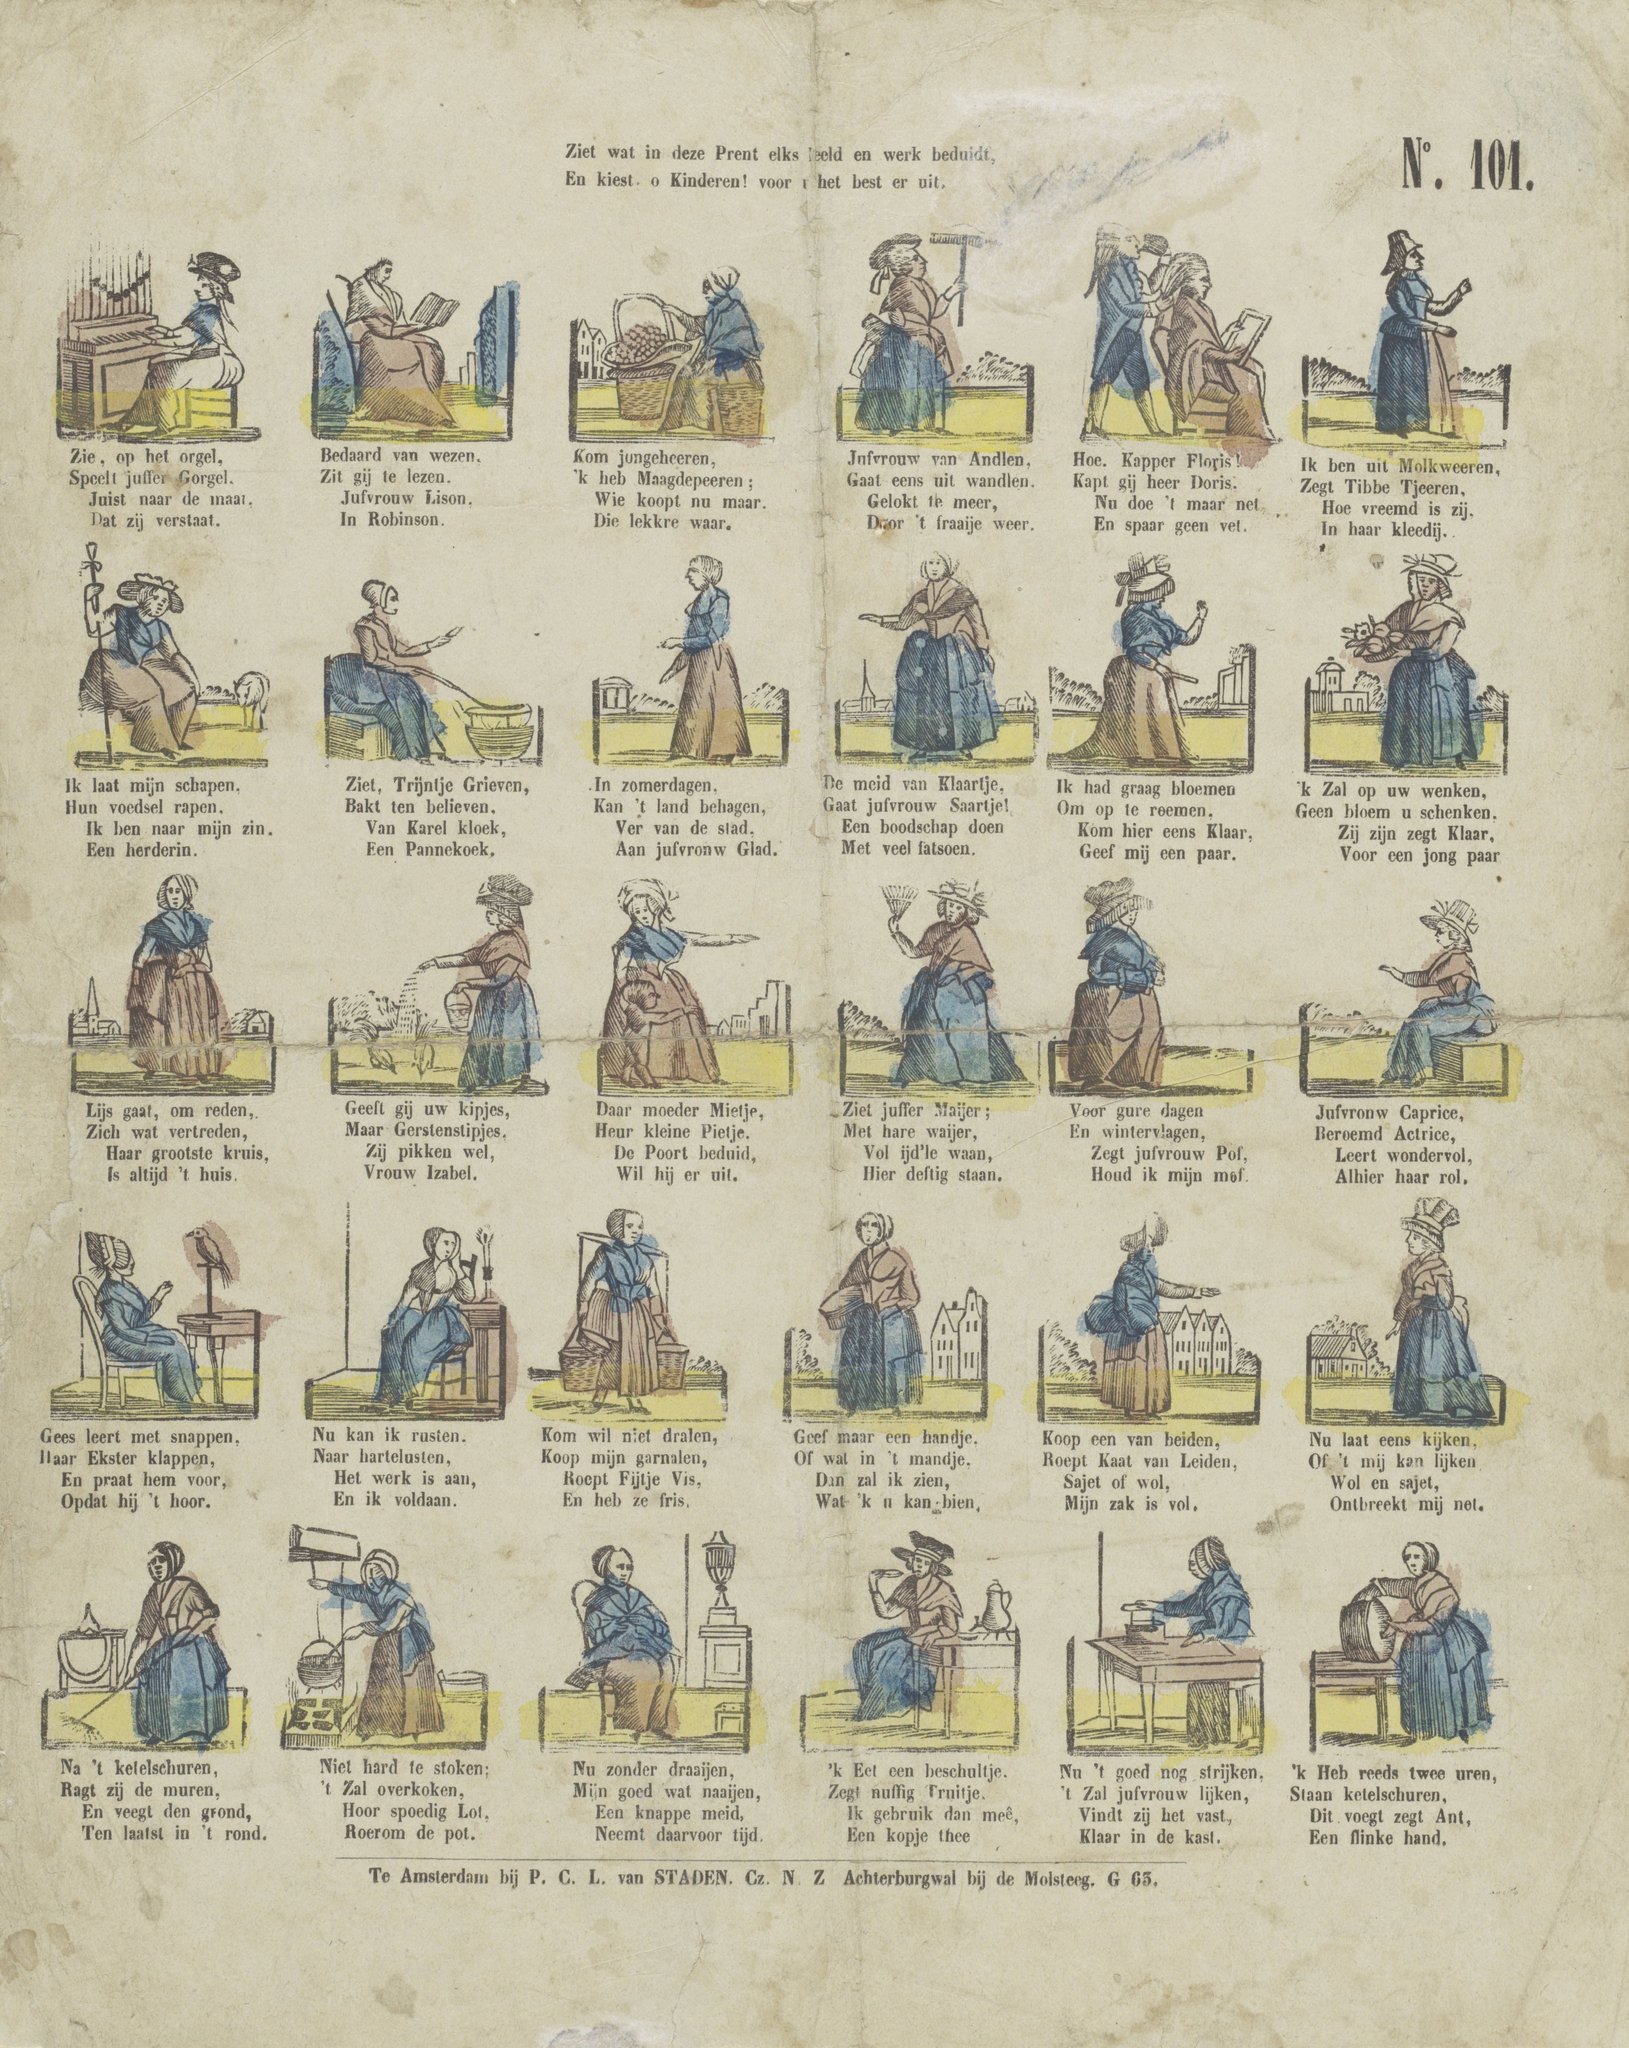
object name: print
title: Ziet wat in deze prent elks beeld en werk beduidt, / En kiest o kinderen! voor u het best er uit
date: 1850-1870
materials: paper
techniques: colour, letterpress printing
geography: amsterdam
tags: fowl (cock, hen, chicken, etc.) (+ feeding animal), making music; musician with instrument, herding, herdsman, herdswoman, shepherd, shepherdess, cowherd, etc., household chores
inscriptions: collector's mark: Lugt 2760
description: Blad met 30 voorstellingen van vrouwelijke bezigheden. Onder elke voorstelling een vierregelig vers. Genummerd rechtsboven: No. 101.